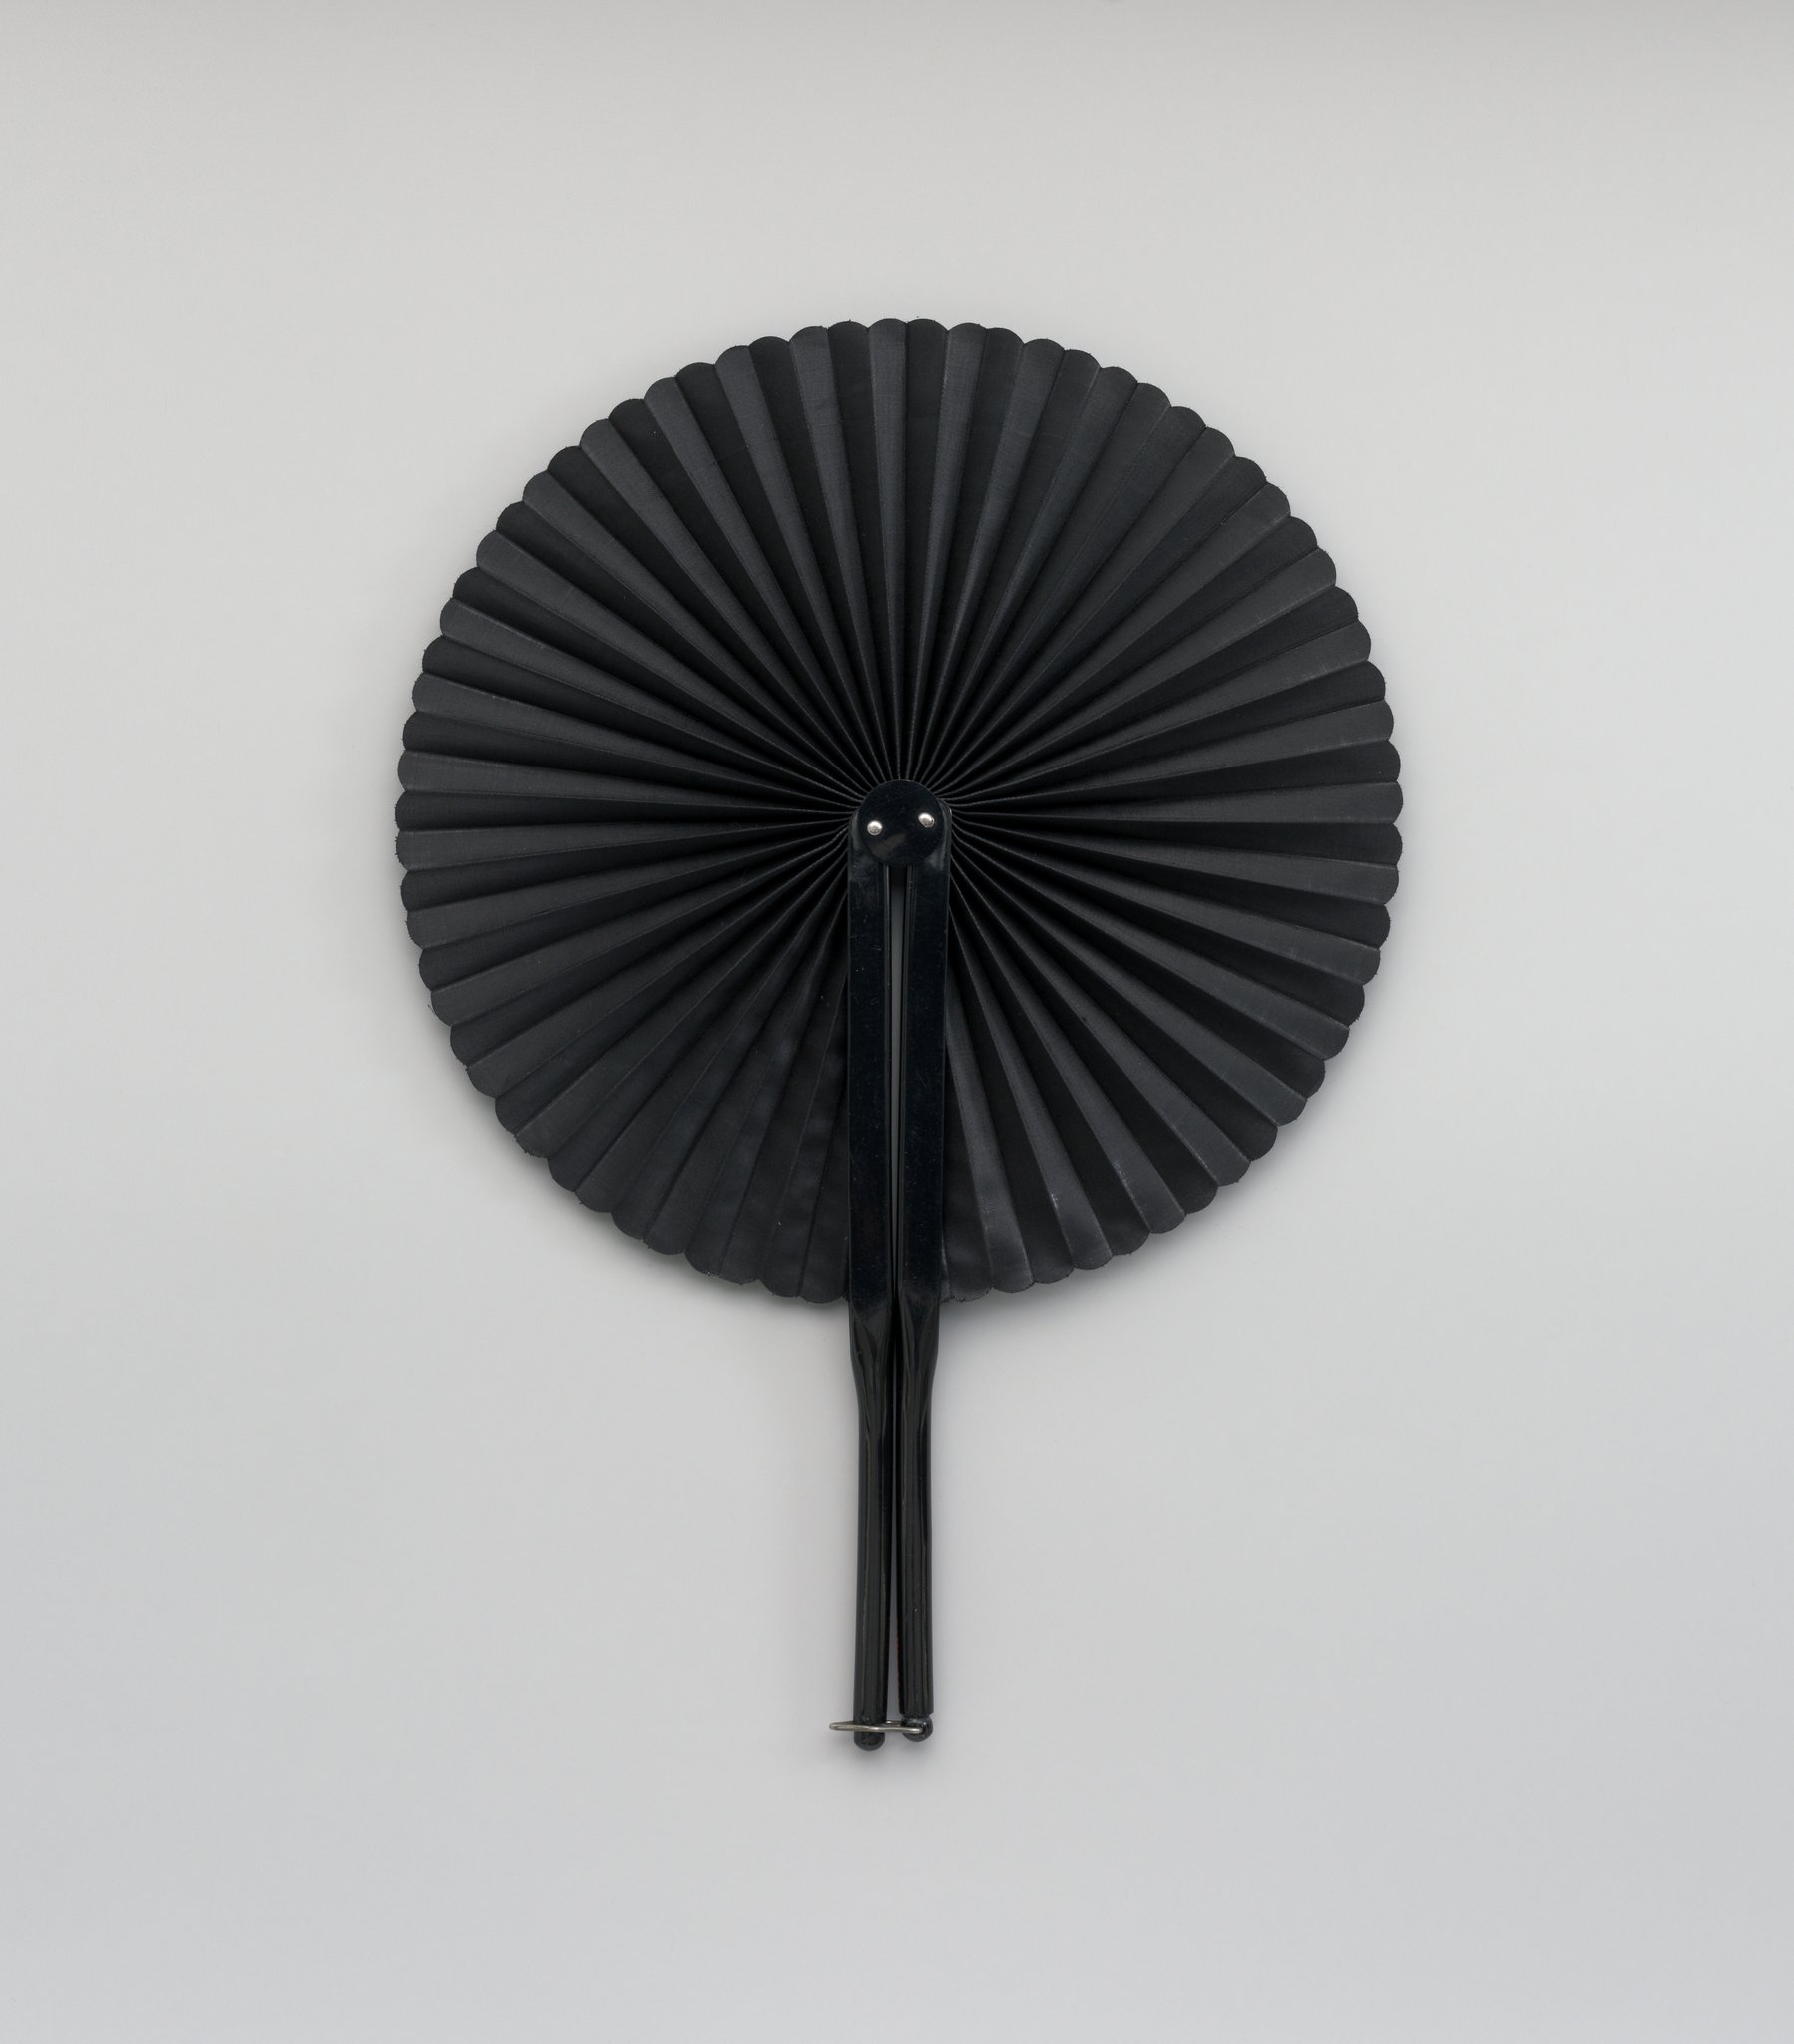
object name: fan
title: Cockade Fan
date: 1801-1900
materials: silk, wood